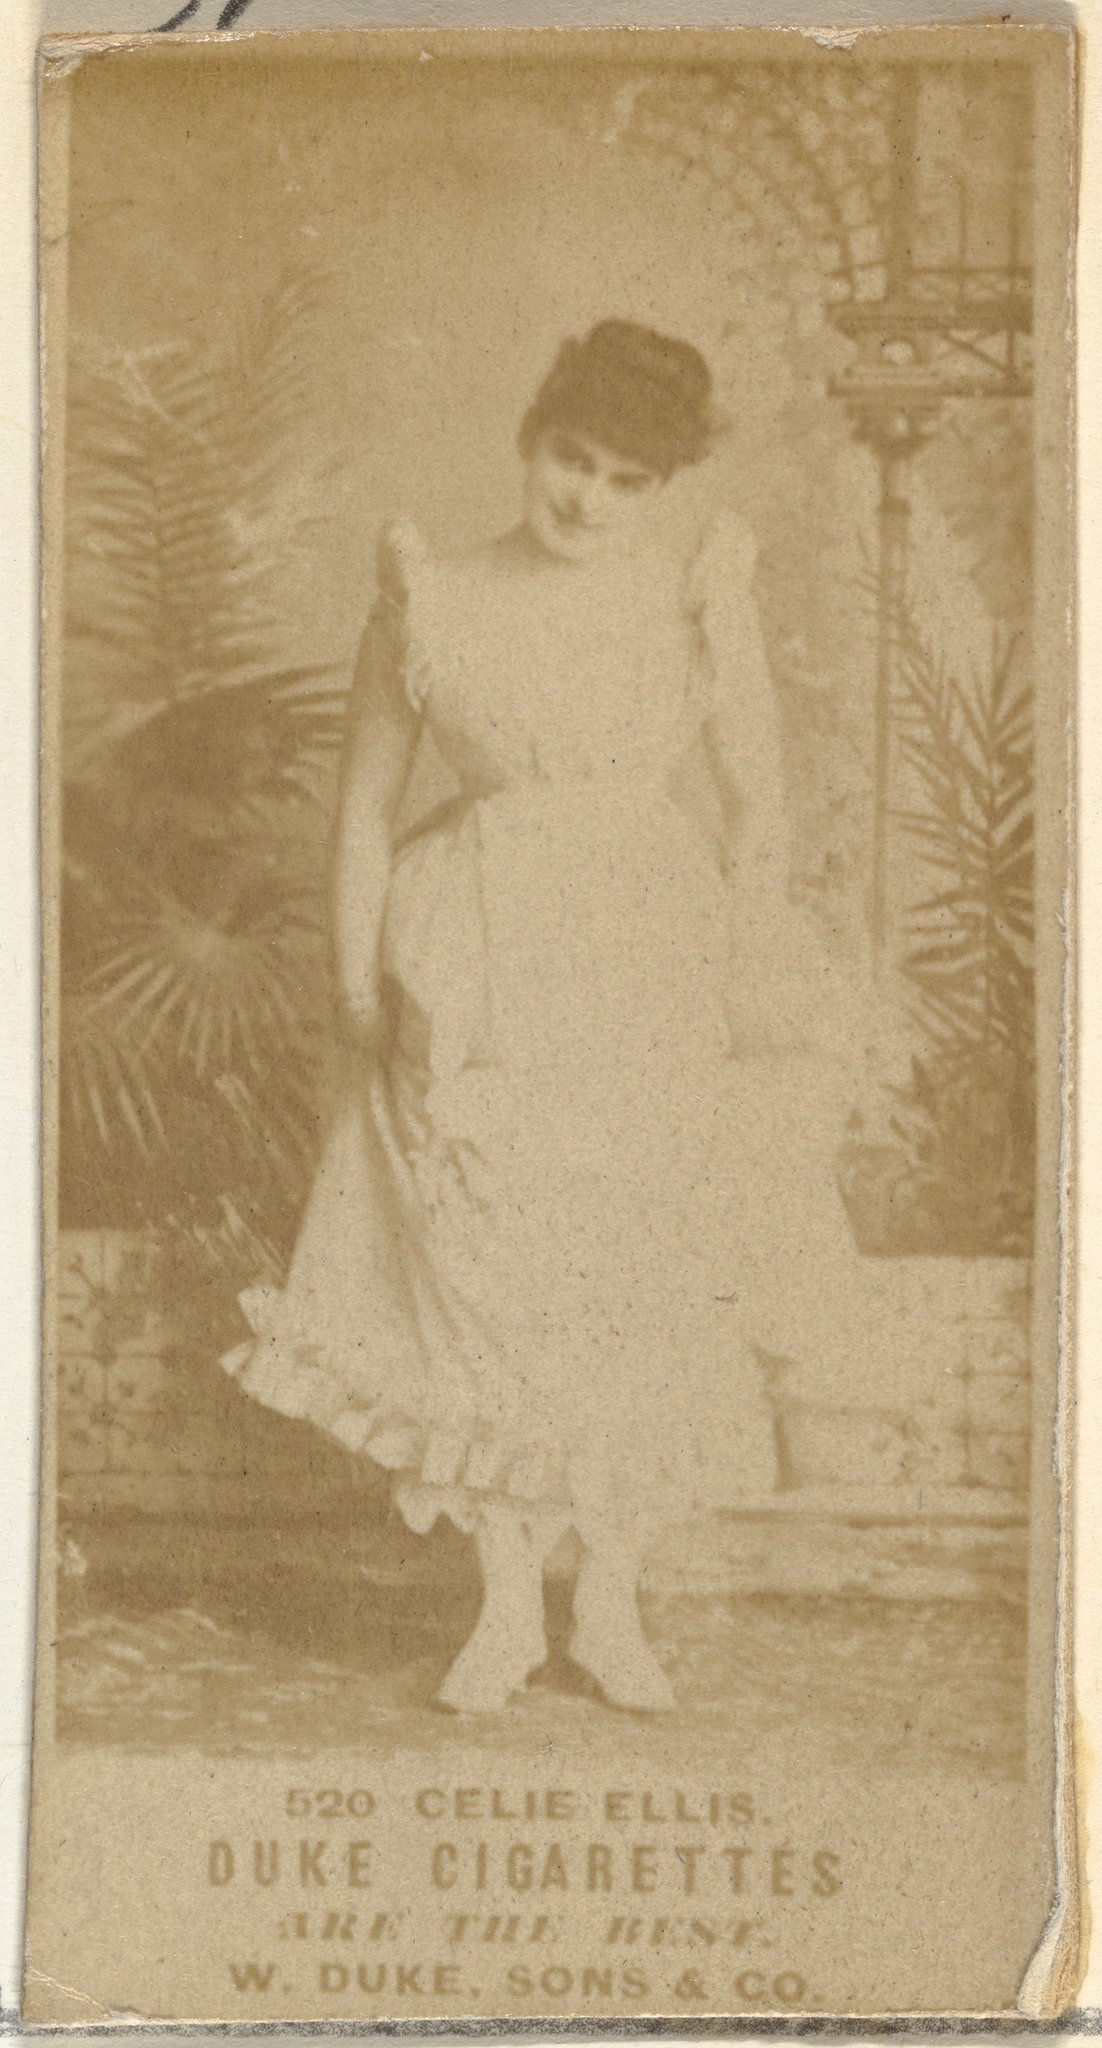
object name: photograph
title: Card Number 520, Celie Ellis, from the Actors and Actresses series (N145-7) issued by Duke Sons & Co. to promote Duke Cigarettes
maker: w. duke, sons & co.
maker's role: publisher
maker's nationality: american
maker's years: 1870-1920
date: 1880-1889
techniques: albumen silver print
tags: portraits,women,actresses